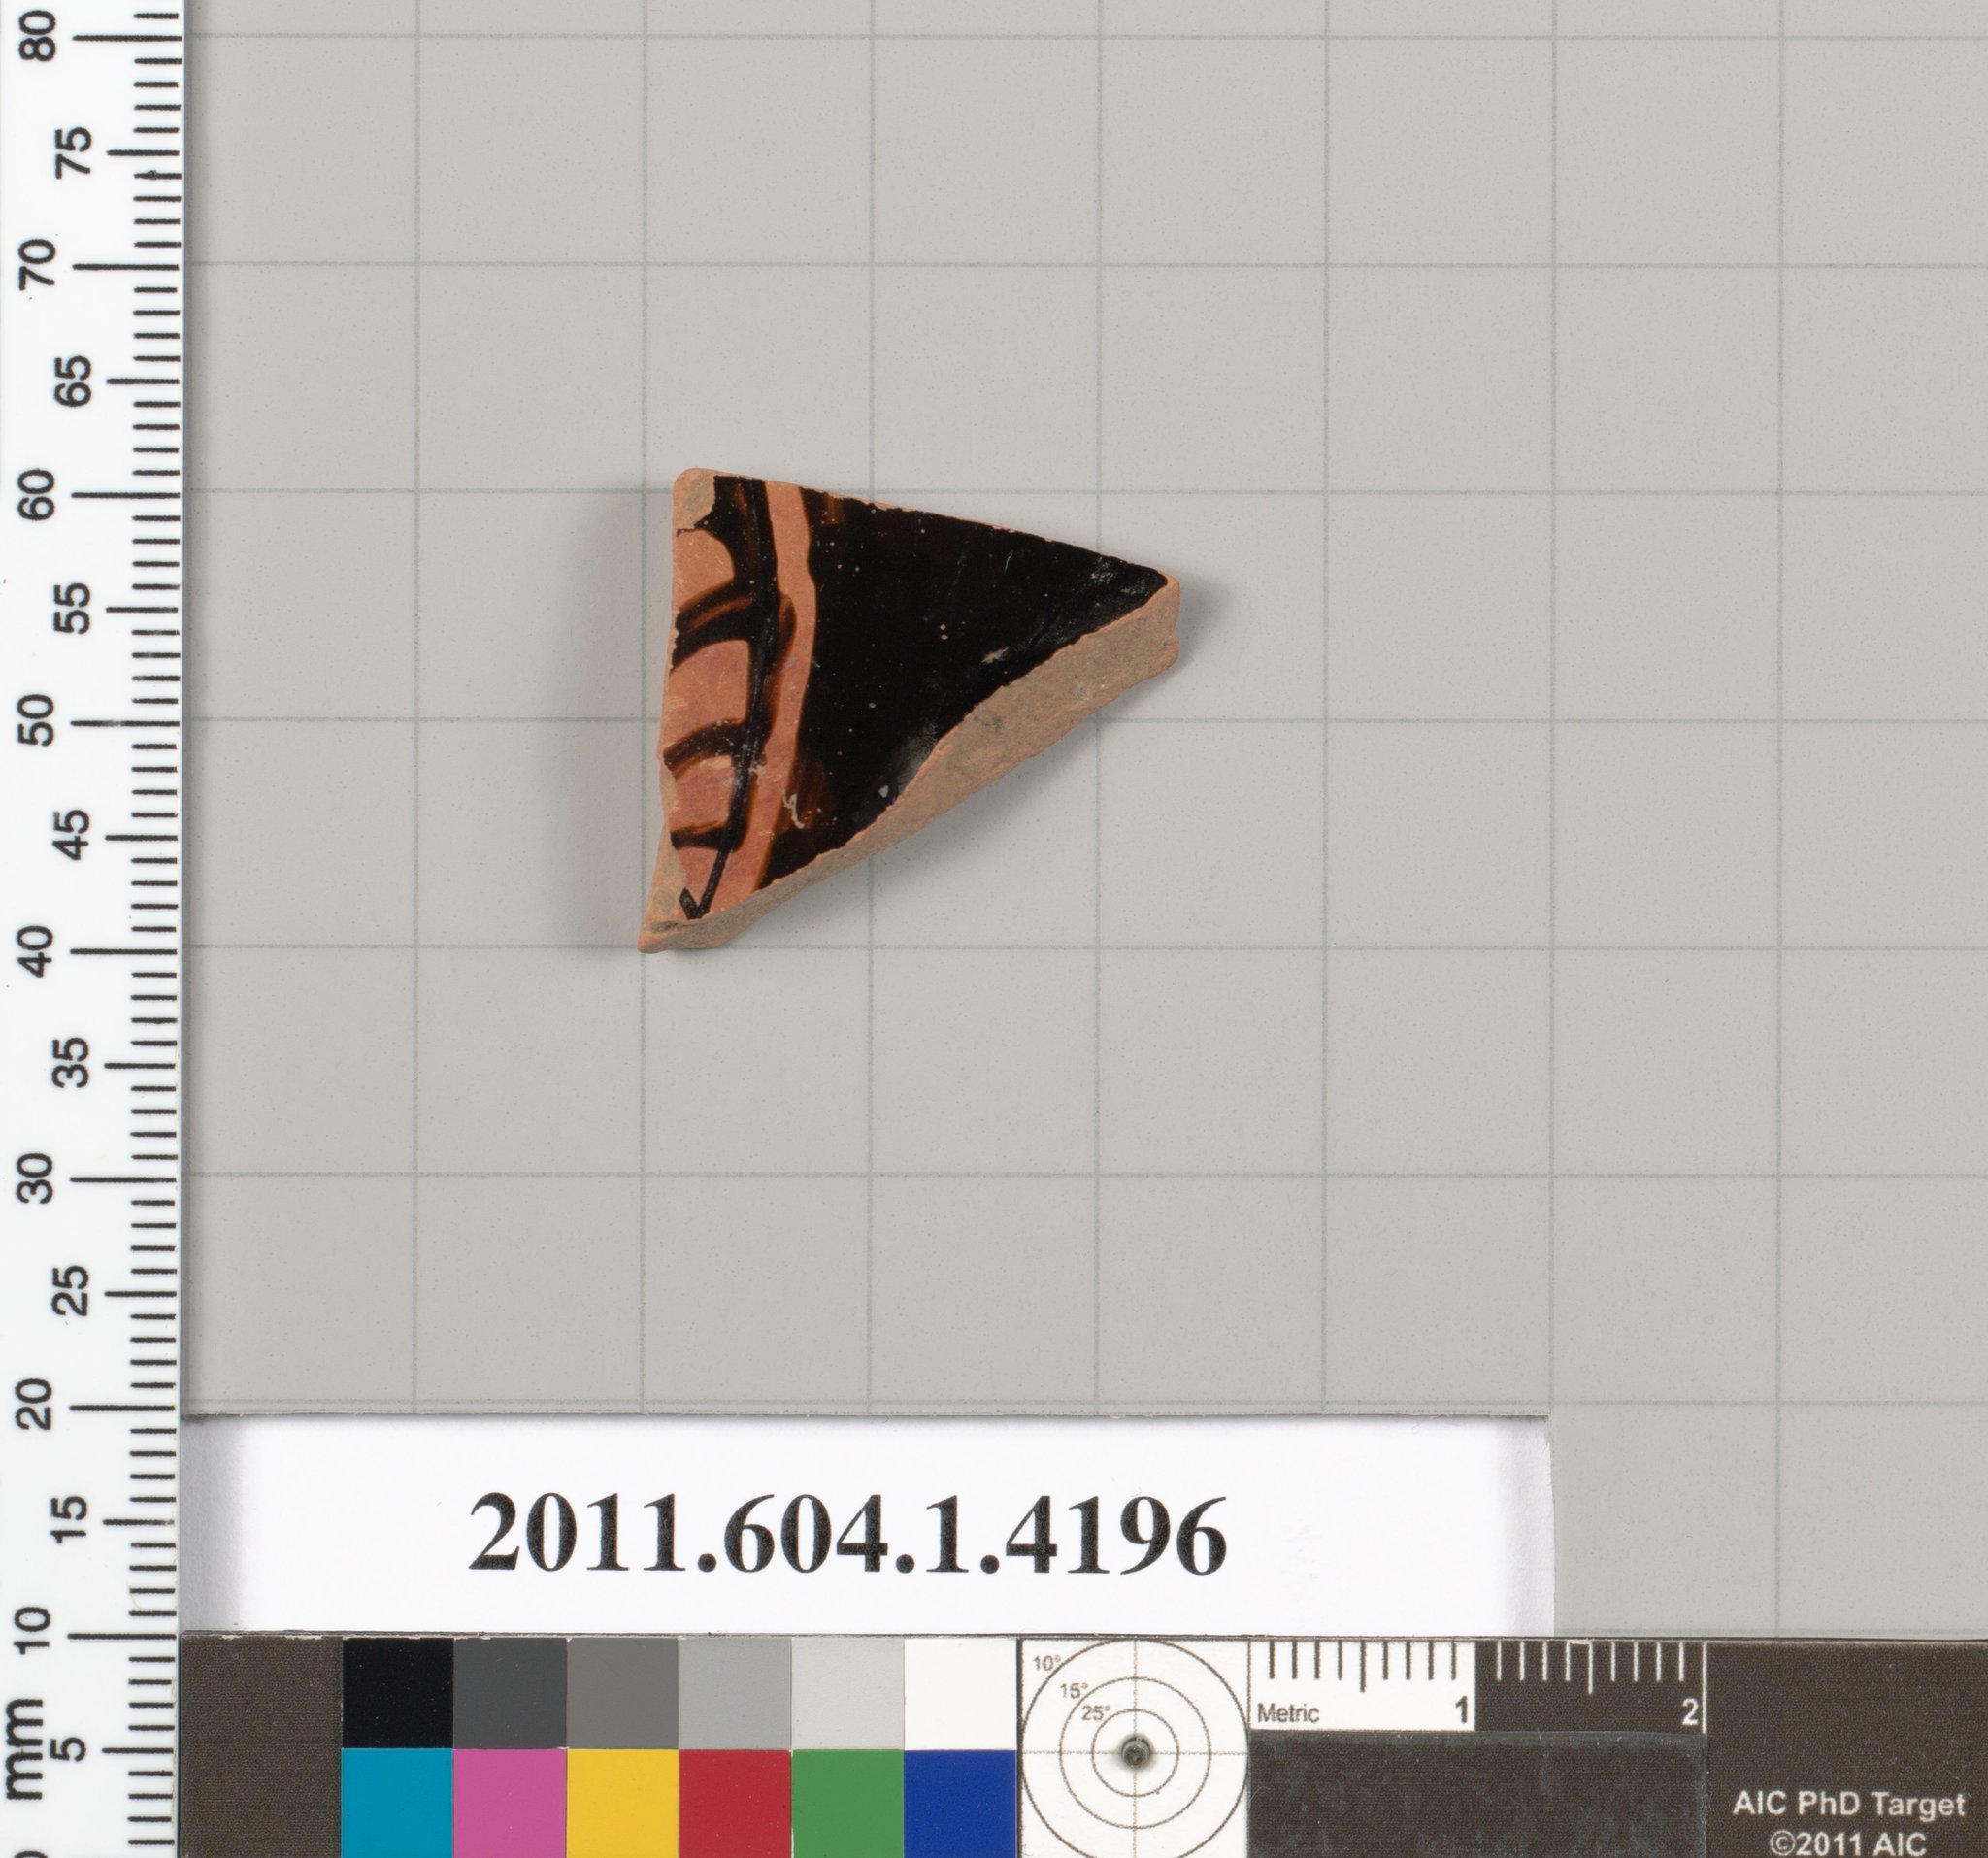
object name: kylix fragment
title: Terracotta fragment of a kylix (drinking cup)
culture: greek, attic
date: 467-435 BCE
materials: terracotta